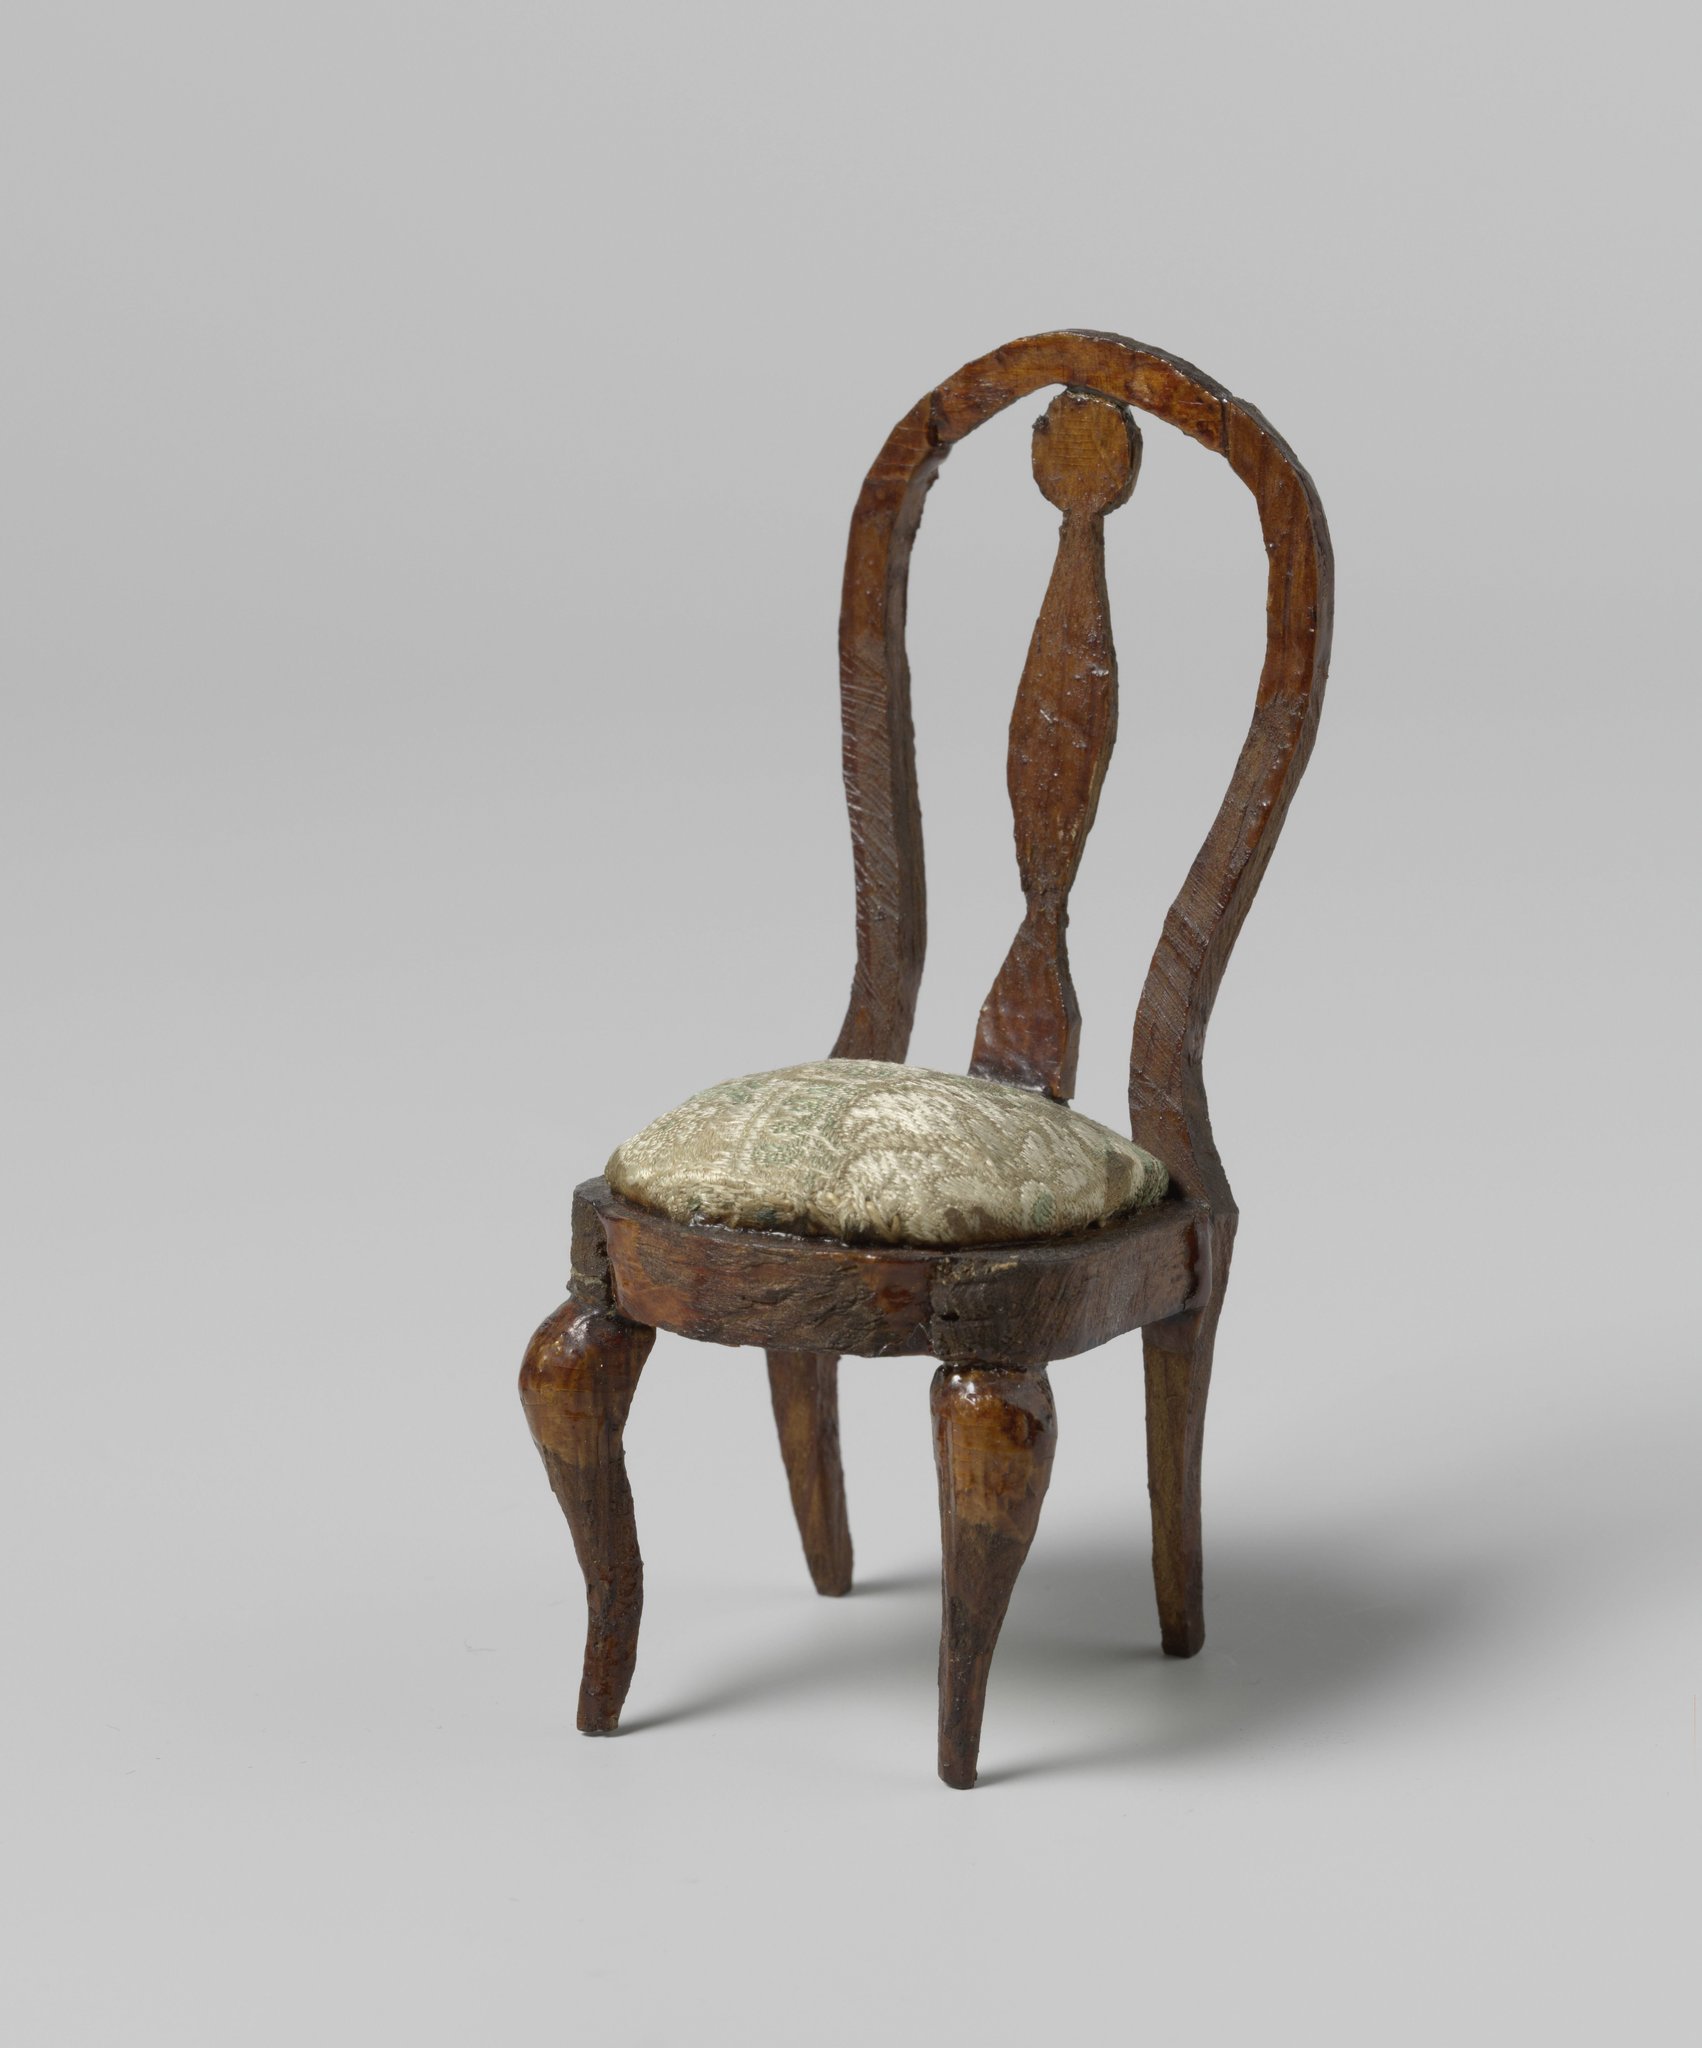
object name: miniature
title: Stoel met ronde, open rugleuningen met middenstijl, de zitting met bloem- en bladmotieven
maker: Anonymous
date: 1750-1800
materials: silk, wood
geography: amsterdam